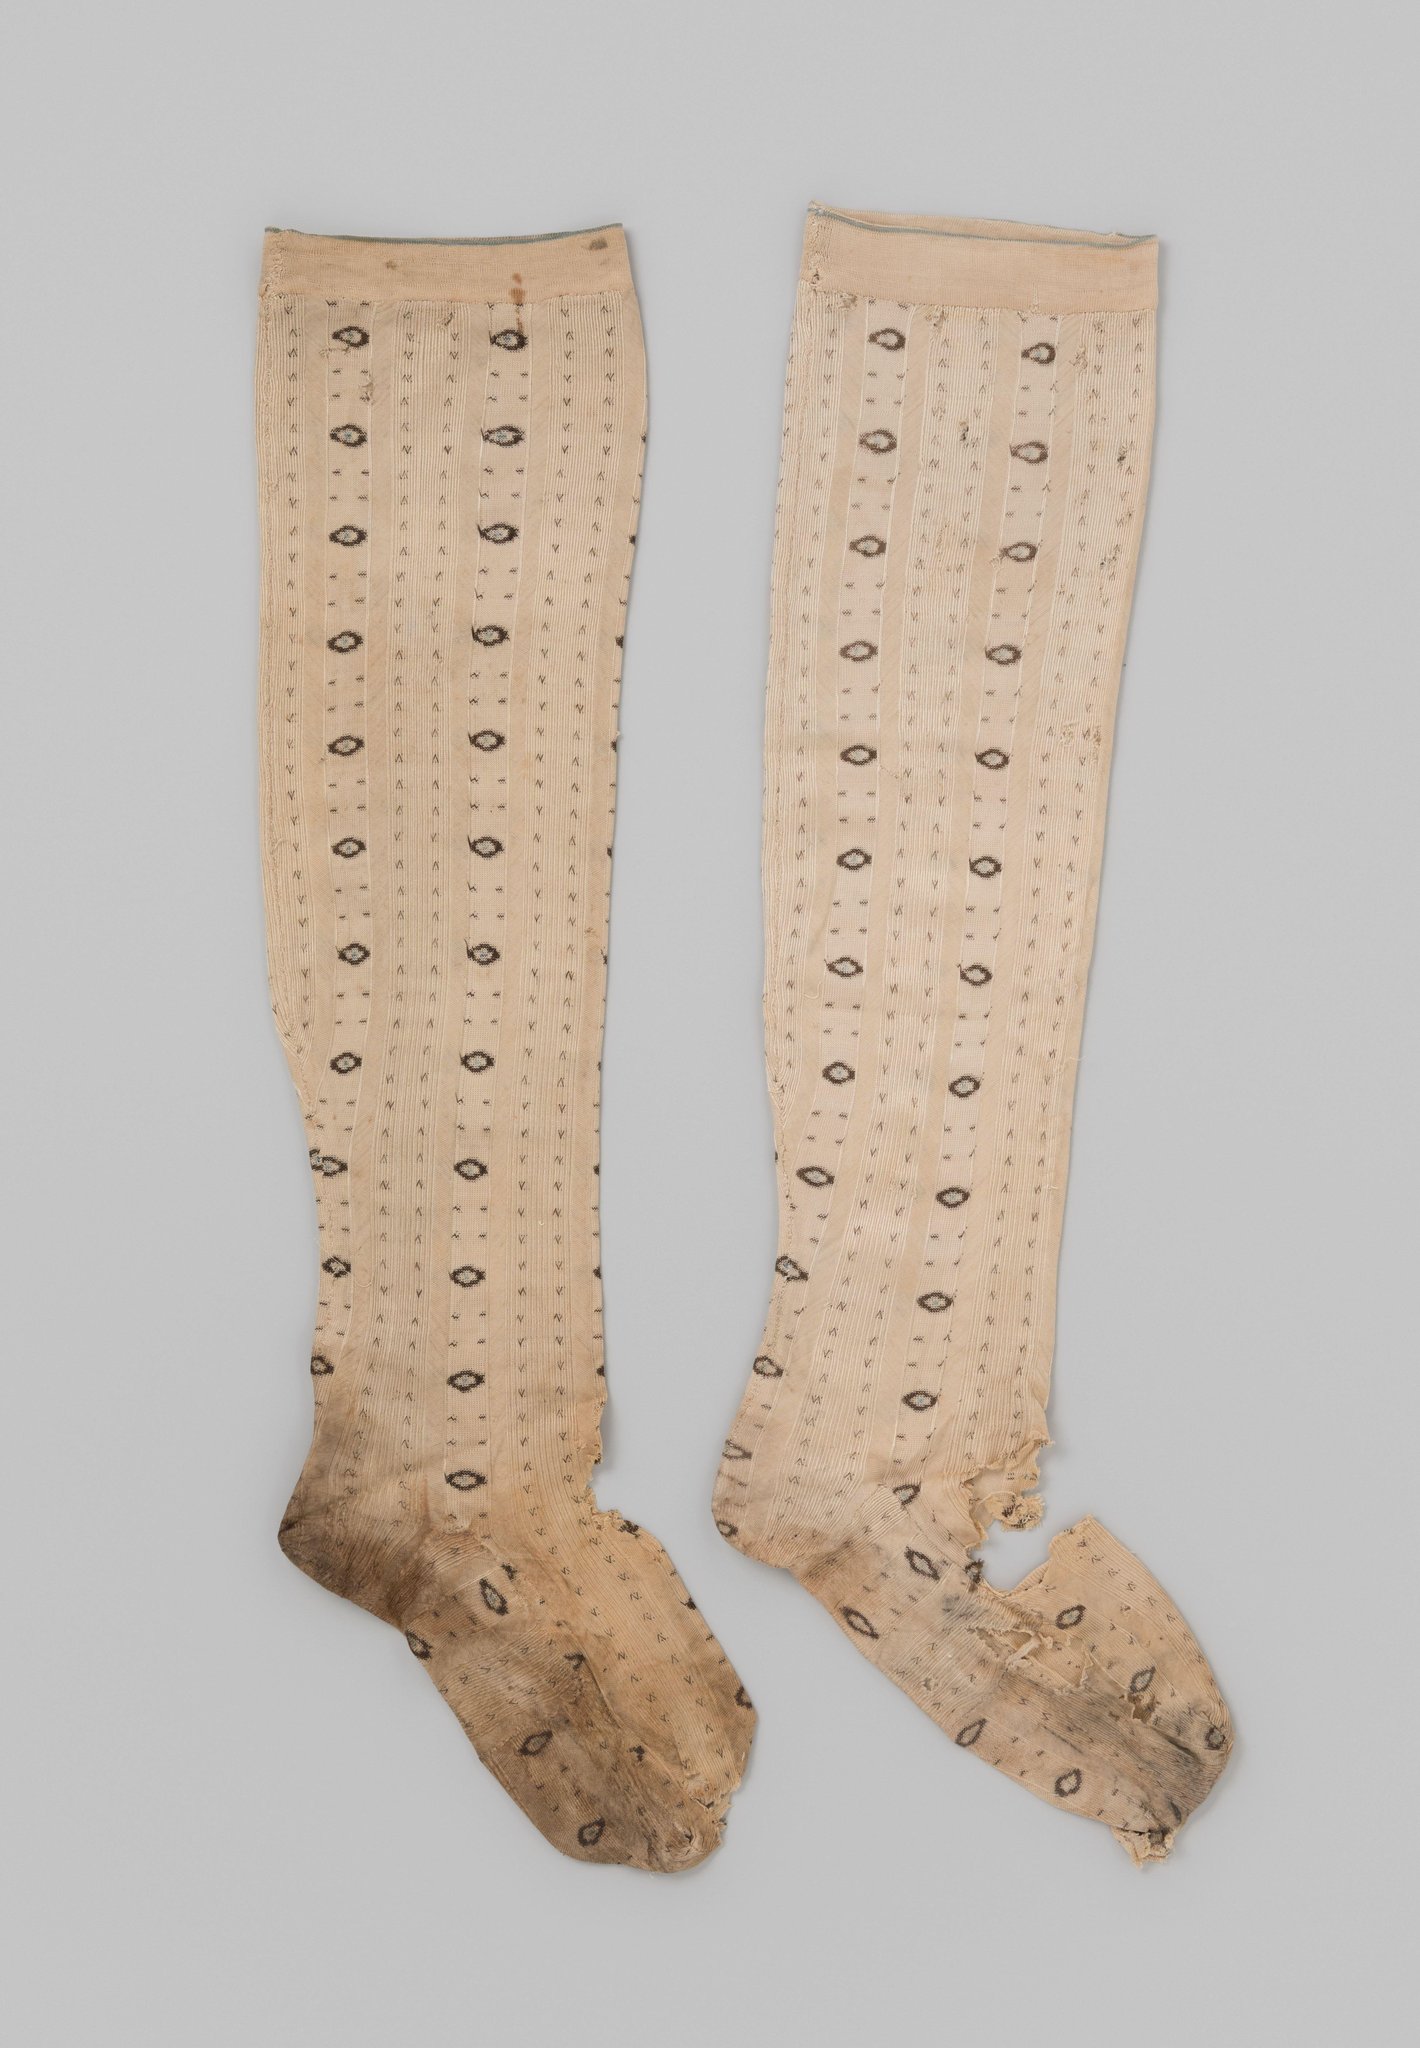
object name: clothing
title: Kous van lichtgele zijde met meegebreide verticale strepen, waarin om en om een ovaalvormig motief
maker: Anonymous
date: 1780-1800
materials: silk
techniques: knitting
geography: netherlands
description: Paar kousen van lichtgele zijde met strepen en figuurtjes, die zijn samengesteld uit een ovaal met blauwe stip en flotterende 'N'-en. Techniek: probleem. Het zwart is aan de achterzijde per steek meegenomen, maar waar het begint en eindigt is niet duidelijk- althans niet met de flotterende draden.